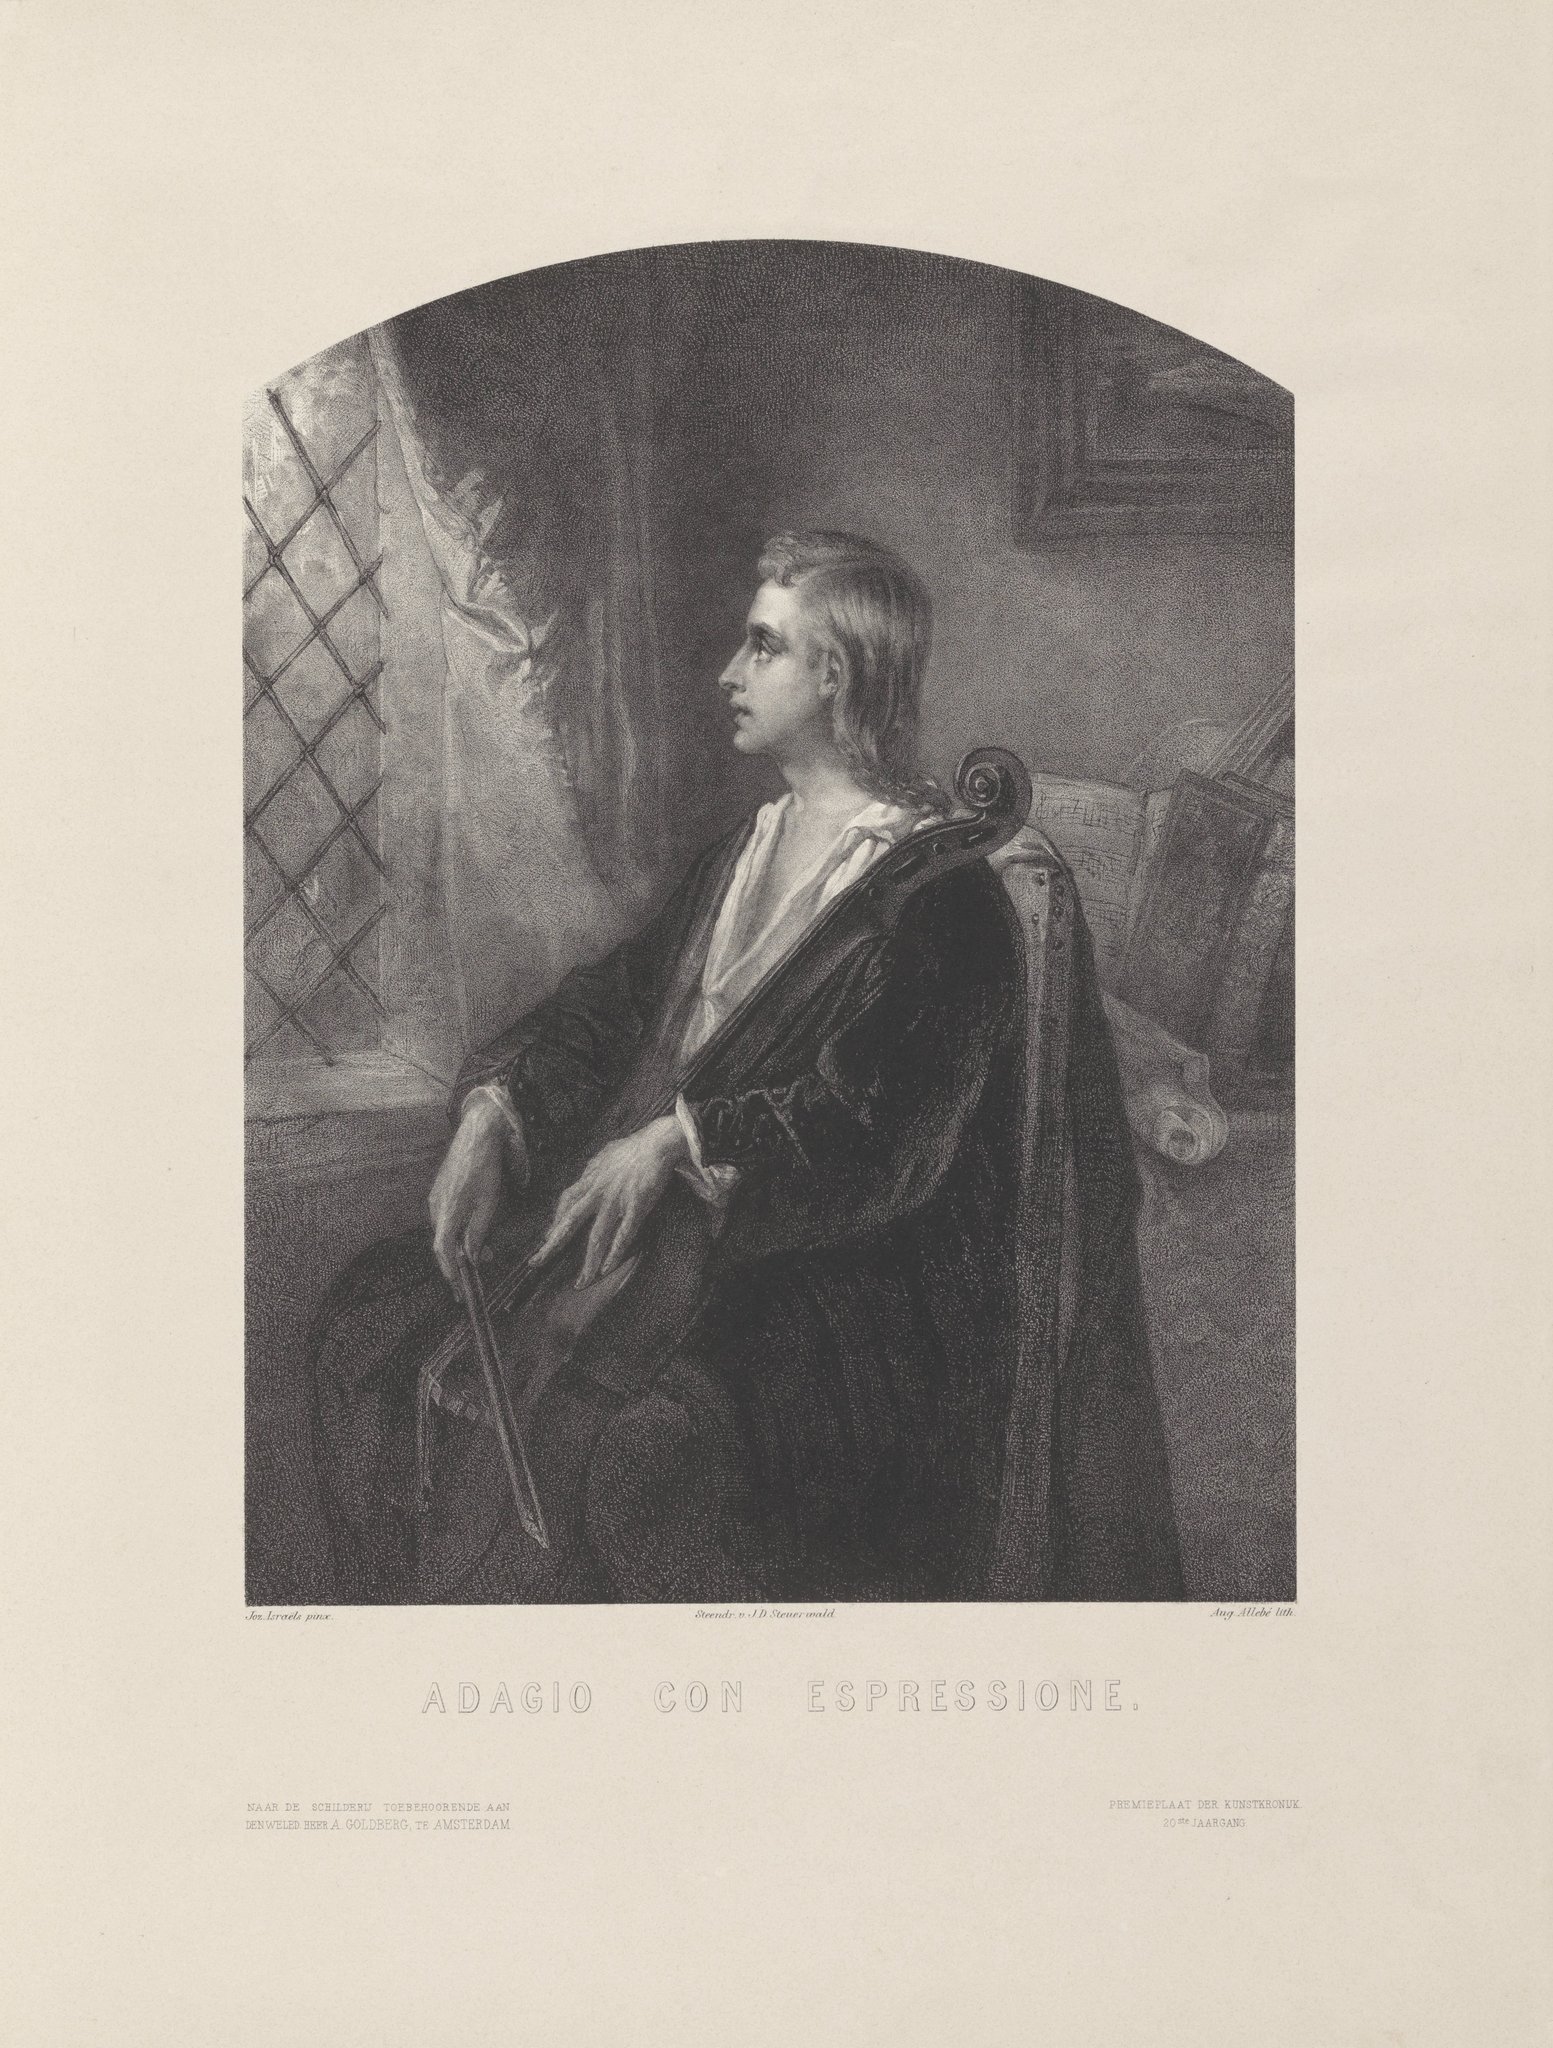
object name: print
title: Adagio con espressione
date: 1858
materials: paper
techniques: lithography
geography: netherlands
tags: one person playing string instrument (bowed), viola, violoncello; double bass, interior of the house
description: Een man bespeelt een cello voor het raam en kijkt naar buiten. Achter hem bladmuziek, boeken een rol papier en een snaarinstrument. Premieplaat bij 'Kunstkronijk'.